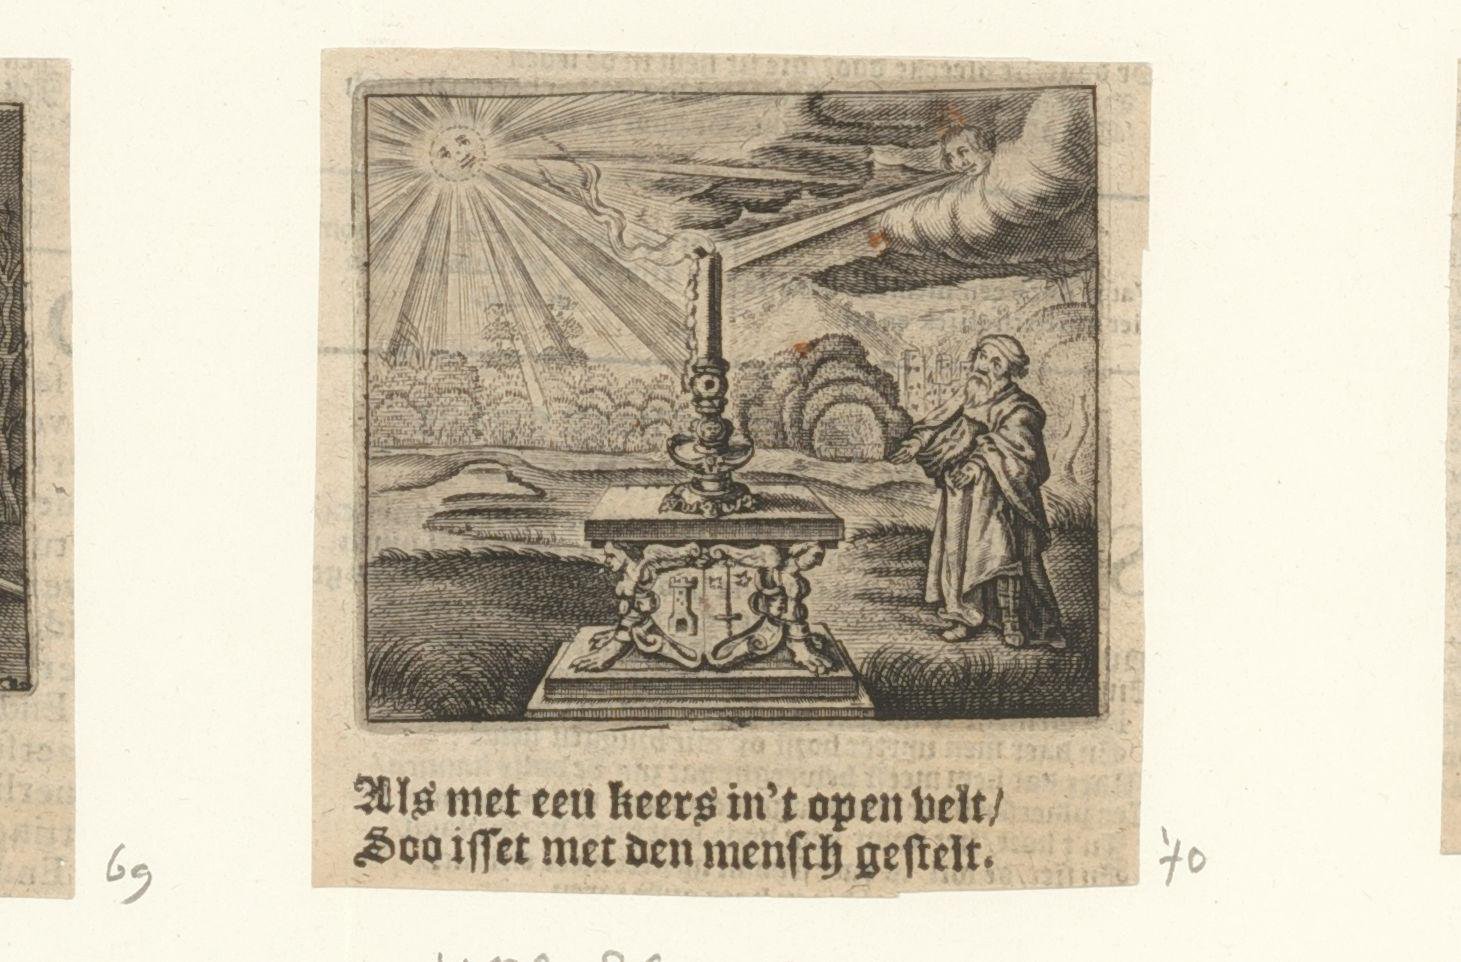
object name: book illustration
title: Oude man geeft een jonge man een lantaarn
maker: Anonymous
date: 1635-1715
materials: paper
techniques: engraving, letterpress printing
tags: proverbs, sayings, etc., candle, sunlight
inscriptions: collector's mark: Lugt 1641, stamp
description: Veel versies van dit embleem verschenen in verschillende uitgave van Spiegel van den Ouden ende Nieuwen Tydt. Zoals: Cats, Jacob. Spiegel van den Ouden ende Nieuwen-tijt, Bestaende uyt Spreeck-woorden (...). Dordrecht: Jacob Braat, 1647. Maar ook in andere publicaties (1665, 1671, 1715, 1722).